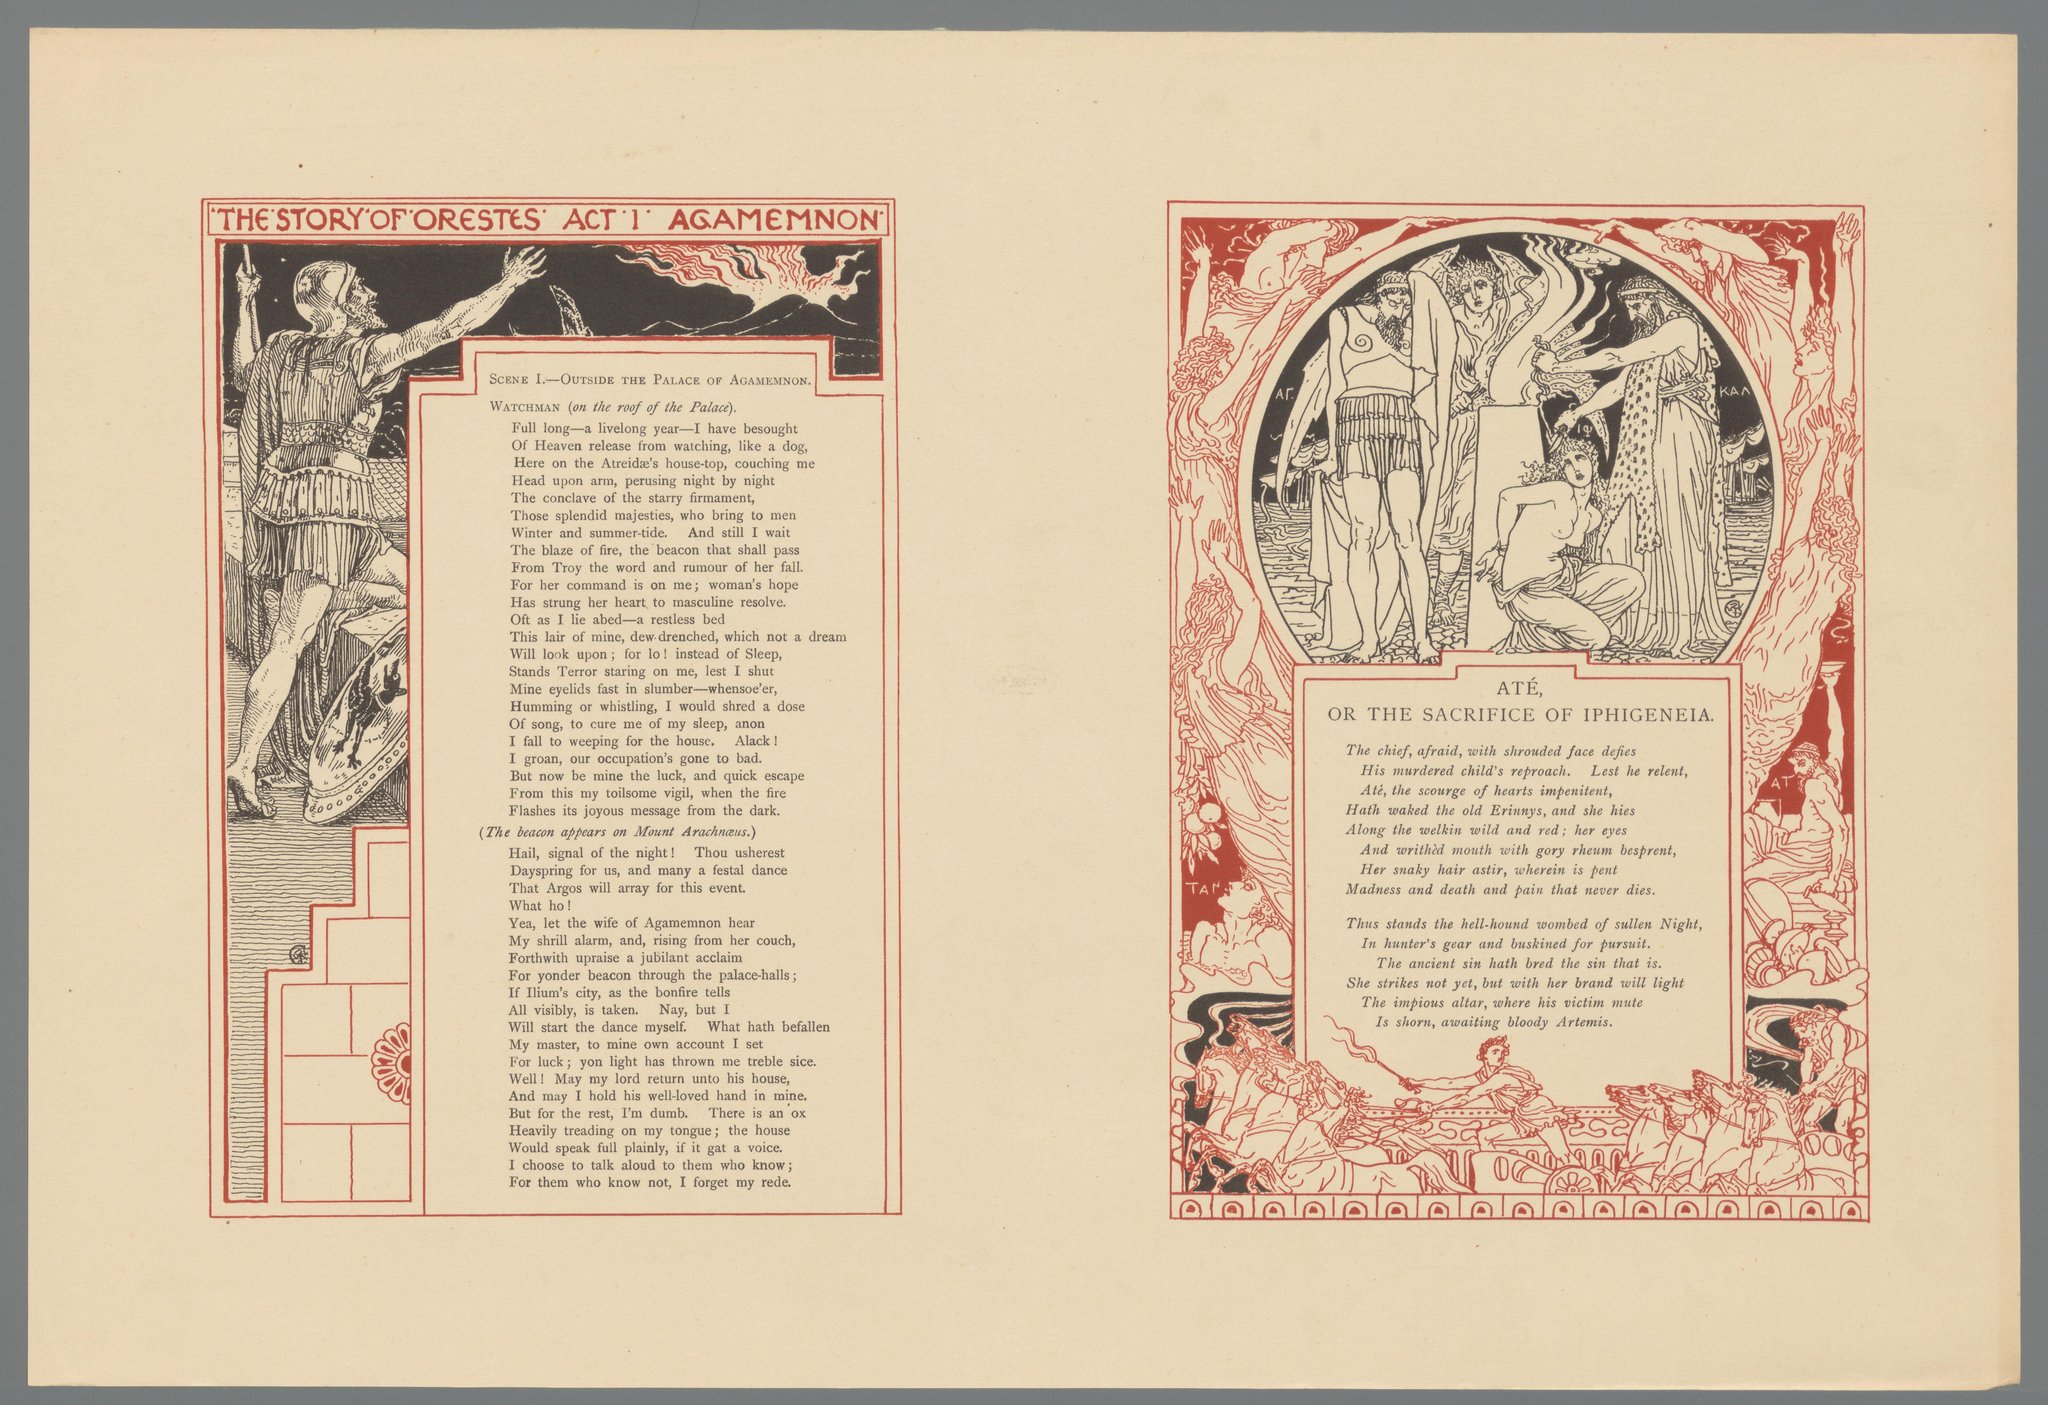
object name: print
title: Wachter en het offer van Iphigeneia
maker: walter crane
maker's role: draughtsman, print maker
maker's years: 1845-1915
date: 1887-1888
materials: paper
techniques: letterpress printing, lithograph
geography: london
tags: the sacrifice of iphigenia, the soldier; the soldier's life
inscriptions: collector's mark: Lugt 2228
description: Prent uit: Warr, George C. Echoes of Hellas: the tale of Troy & the story of Orestes from Homer & Aeschylus. Londen: Marcus Ward & Company, [1887/1888].